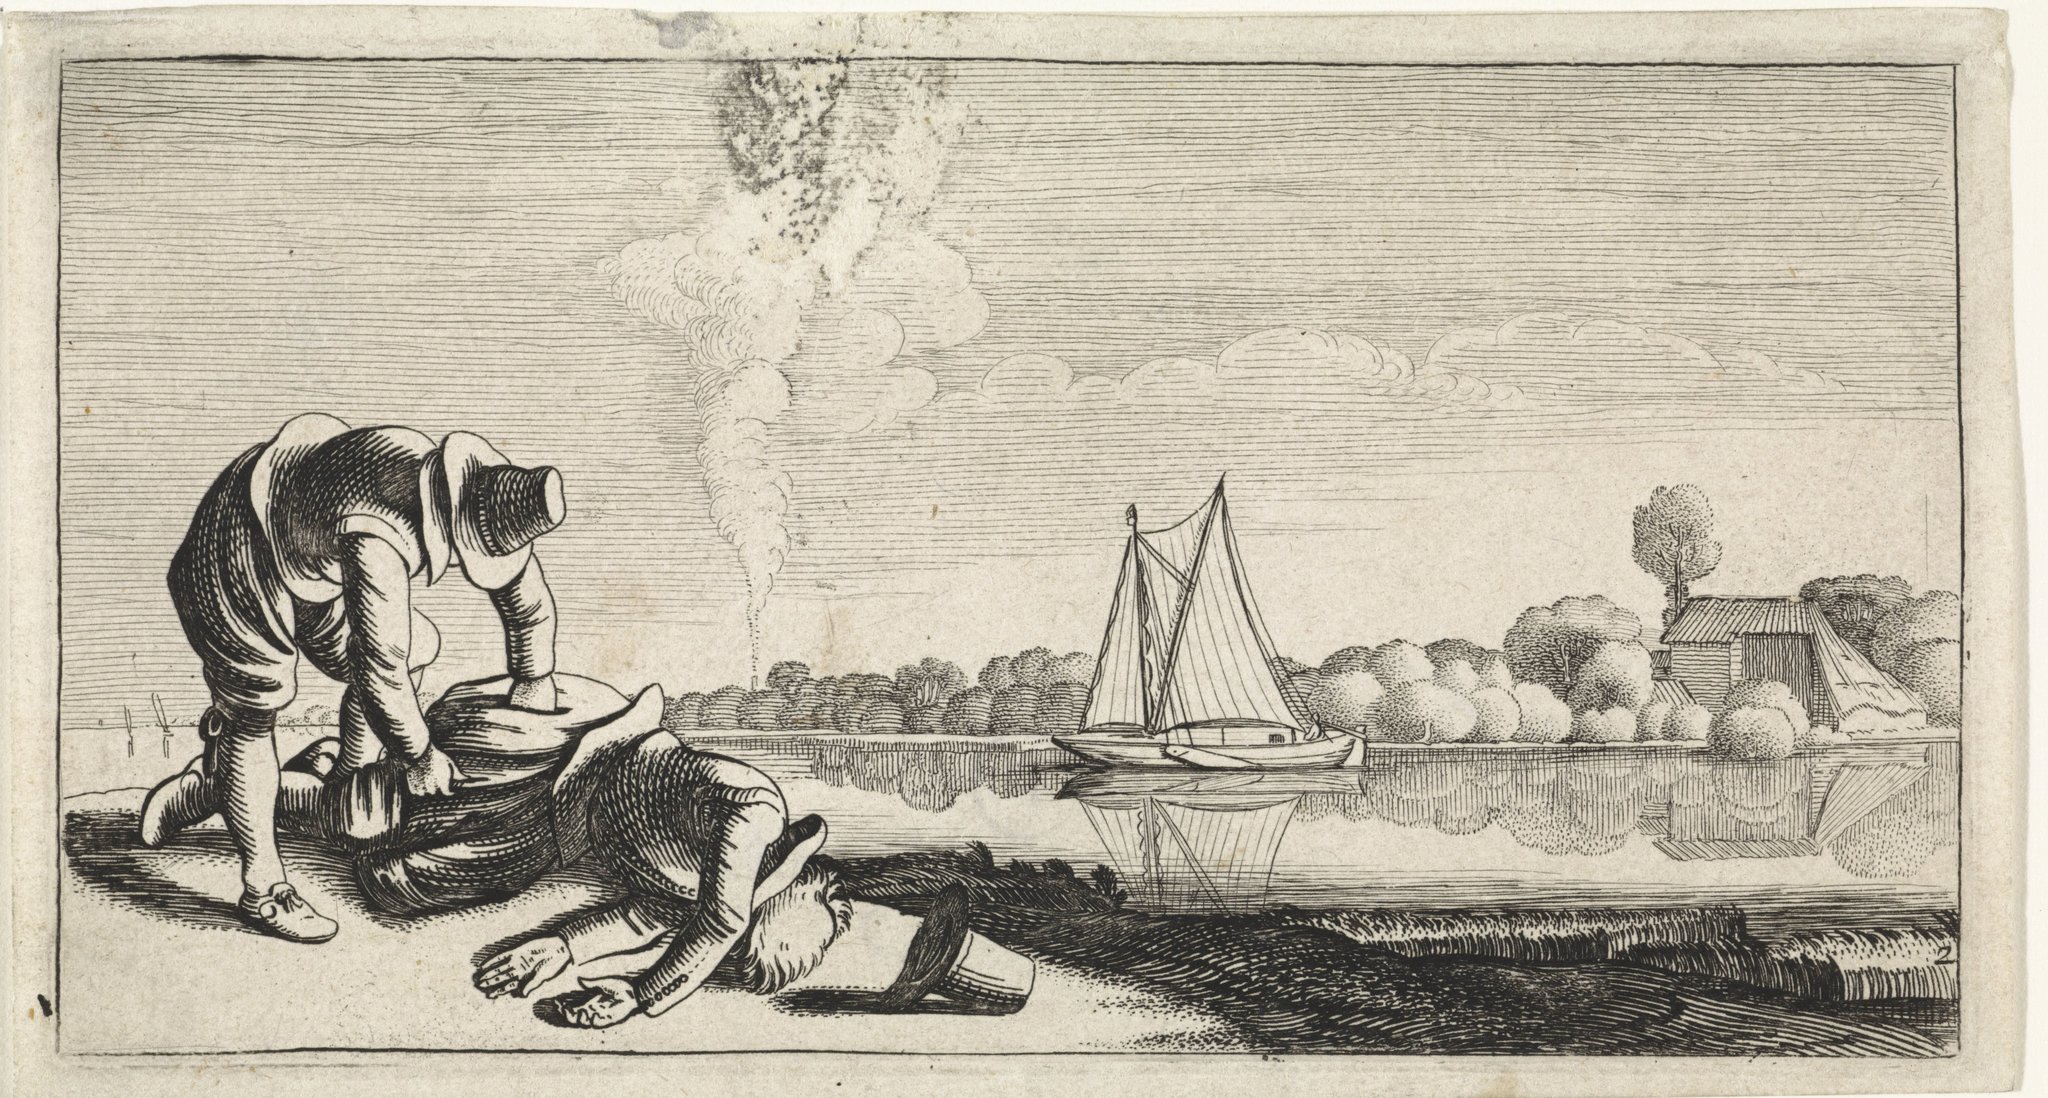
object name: print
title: Vita brevis, spes longa homini, caecusq meatus Pars inopes mundi quantu lacunque sumus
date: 1603-1652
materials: paper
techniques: engraving, etching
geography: northern netherlands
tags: smoke-stack, river, robber, the corpse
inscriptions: collector's mark: Lugt 964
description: Een dode op de oever van een rivier wordt beroofd. Op de rivier een zeilschip en aan de horizon een rookpluim. Tweede prent uit een serie van zes.